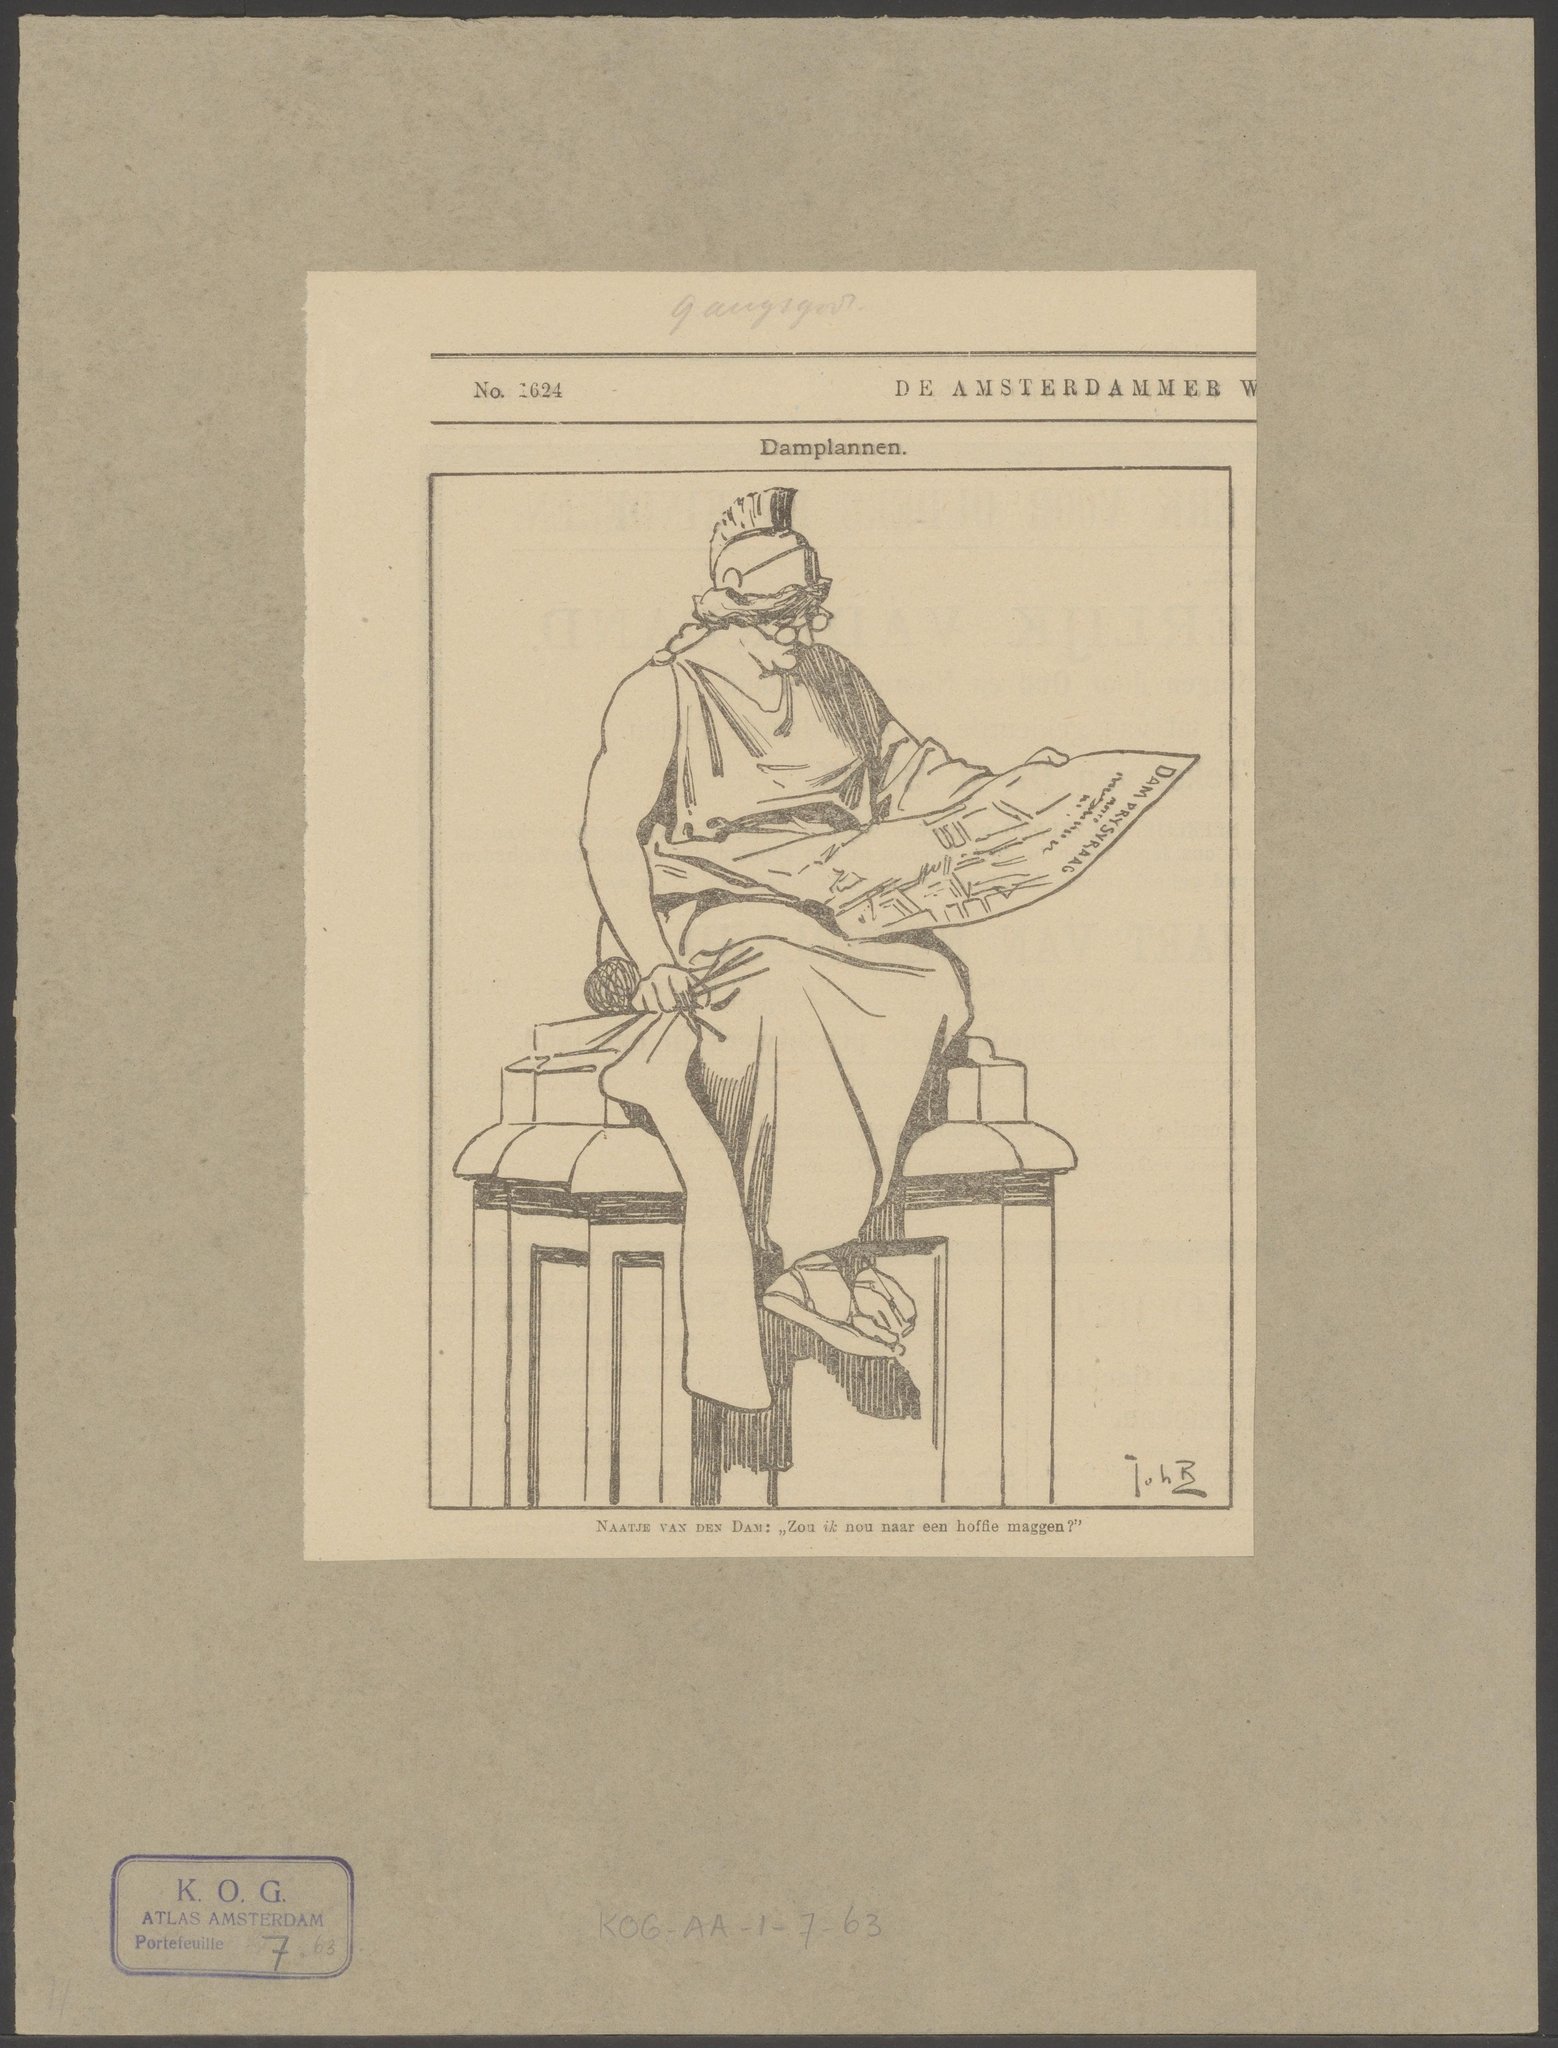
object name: cartoon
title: Spotprent over het verwijderen van het Naatje op de Dam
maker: johan braakensiek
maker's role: draughtsman, print maker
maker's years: 1858-1940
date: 1913-1914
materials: paper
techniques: woodcut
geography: amsterdam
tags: monument, statue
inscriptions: collector's mark: ‘7’ Lugt 1641b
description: Prent uit een editie van: De Groene Amsterdammer (1913-1914).